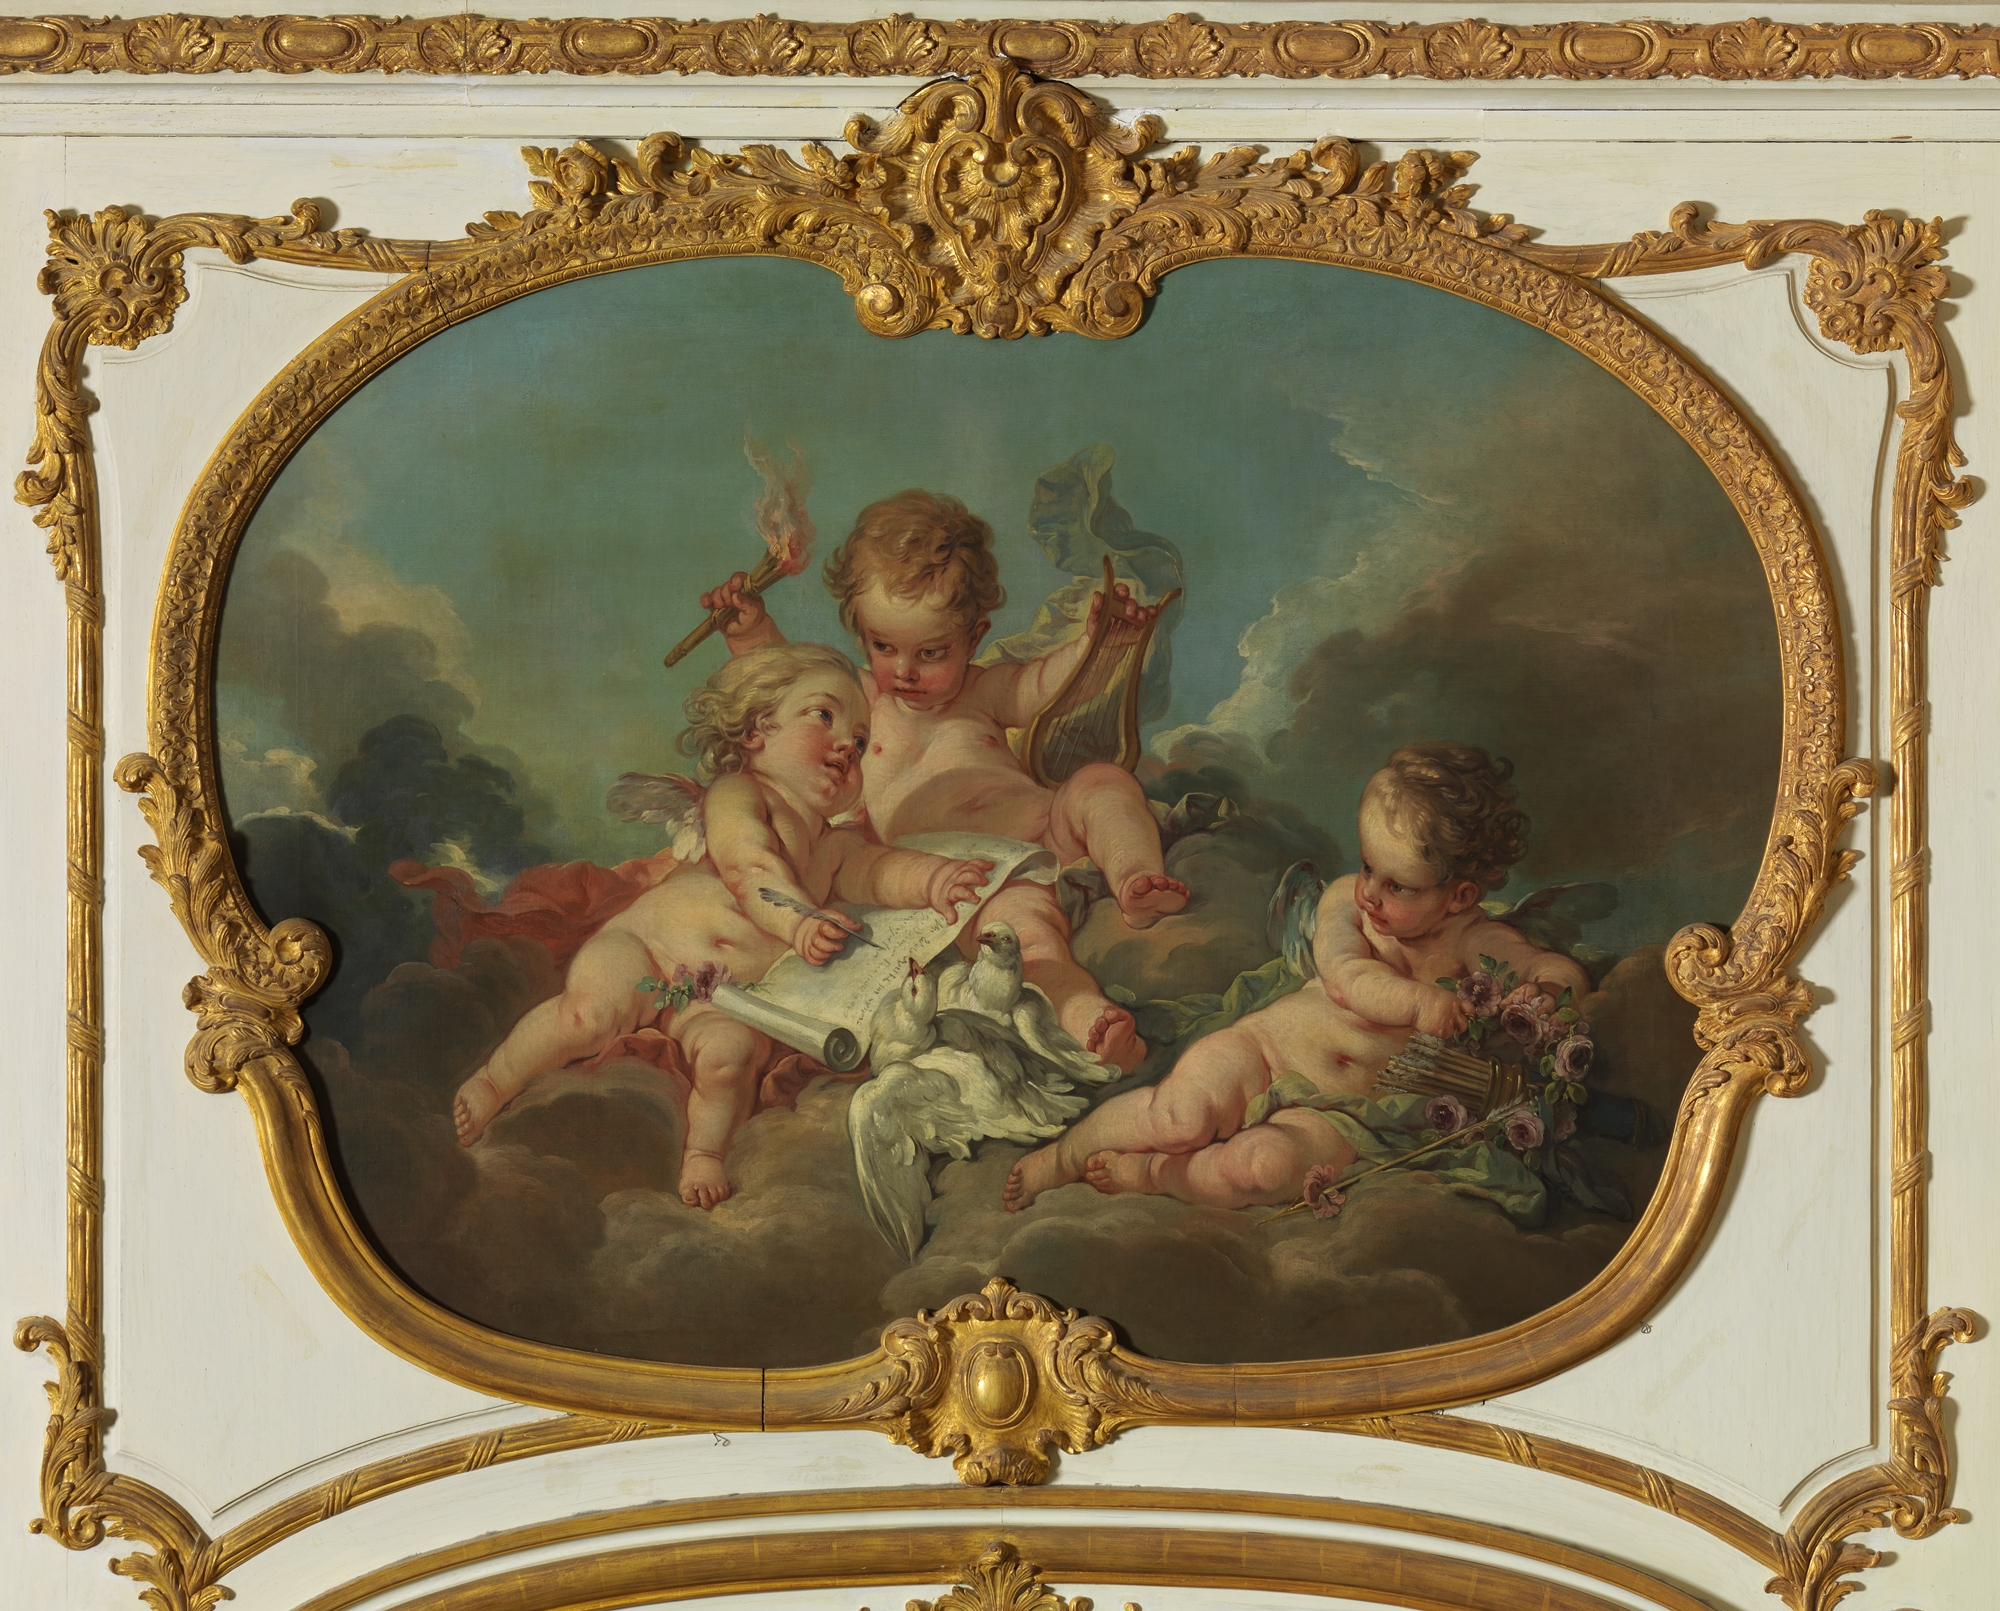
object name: painting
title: Allegory of Lyric Poetry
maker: françois boucher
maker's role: artist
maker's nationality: french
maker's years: 1703-1770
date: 1753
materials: canvas, oil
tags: musical instruments,doves,putti,writing